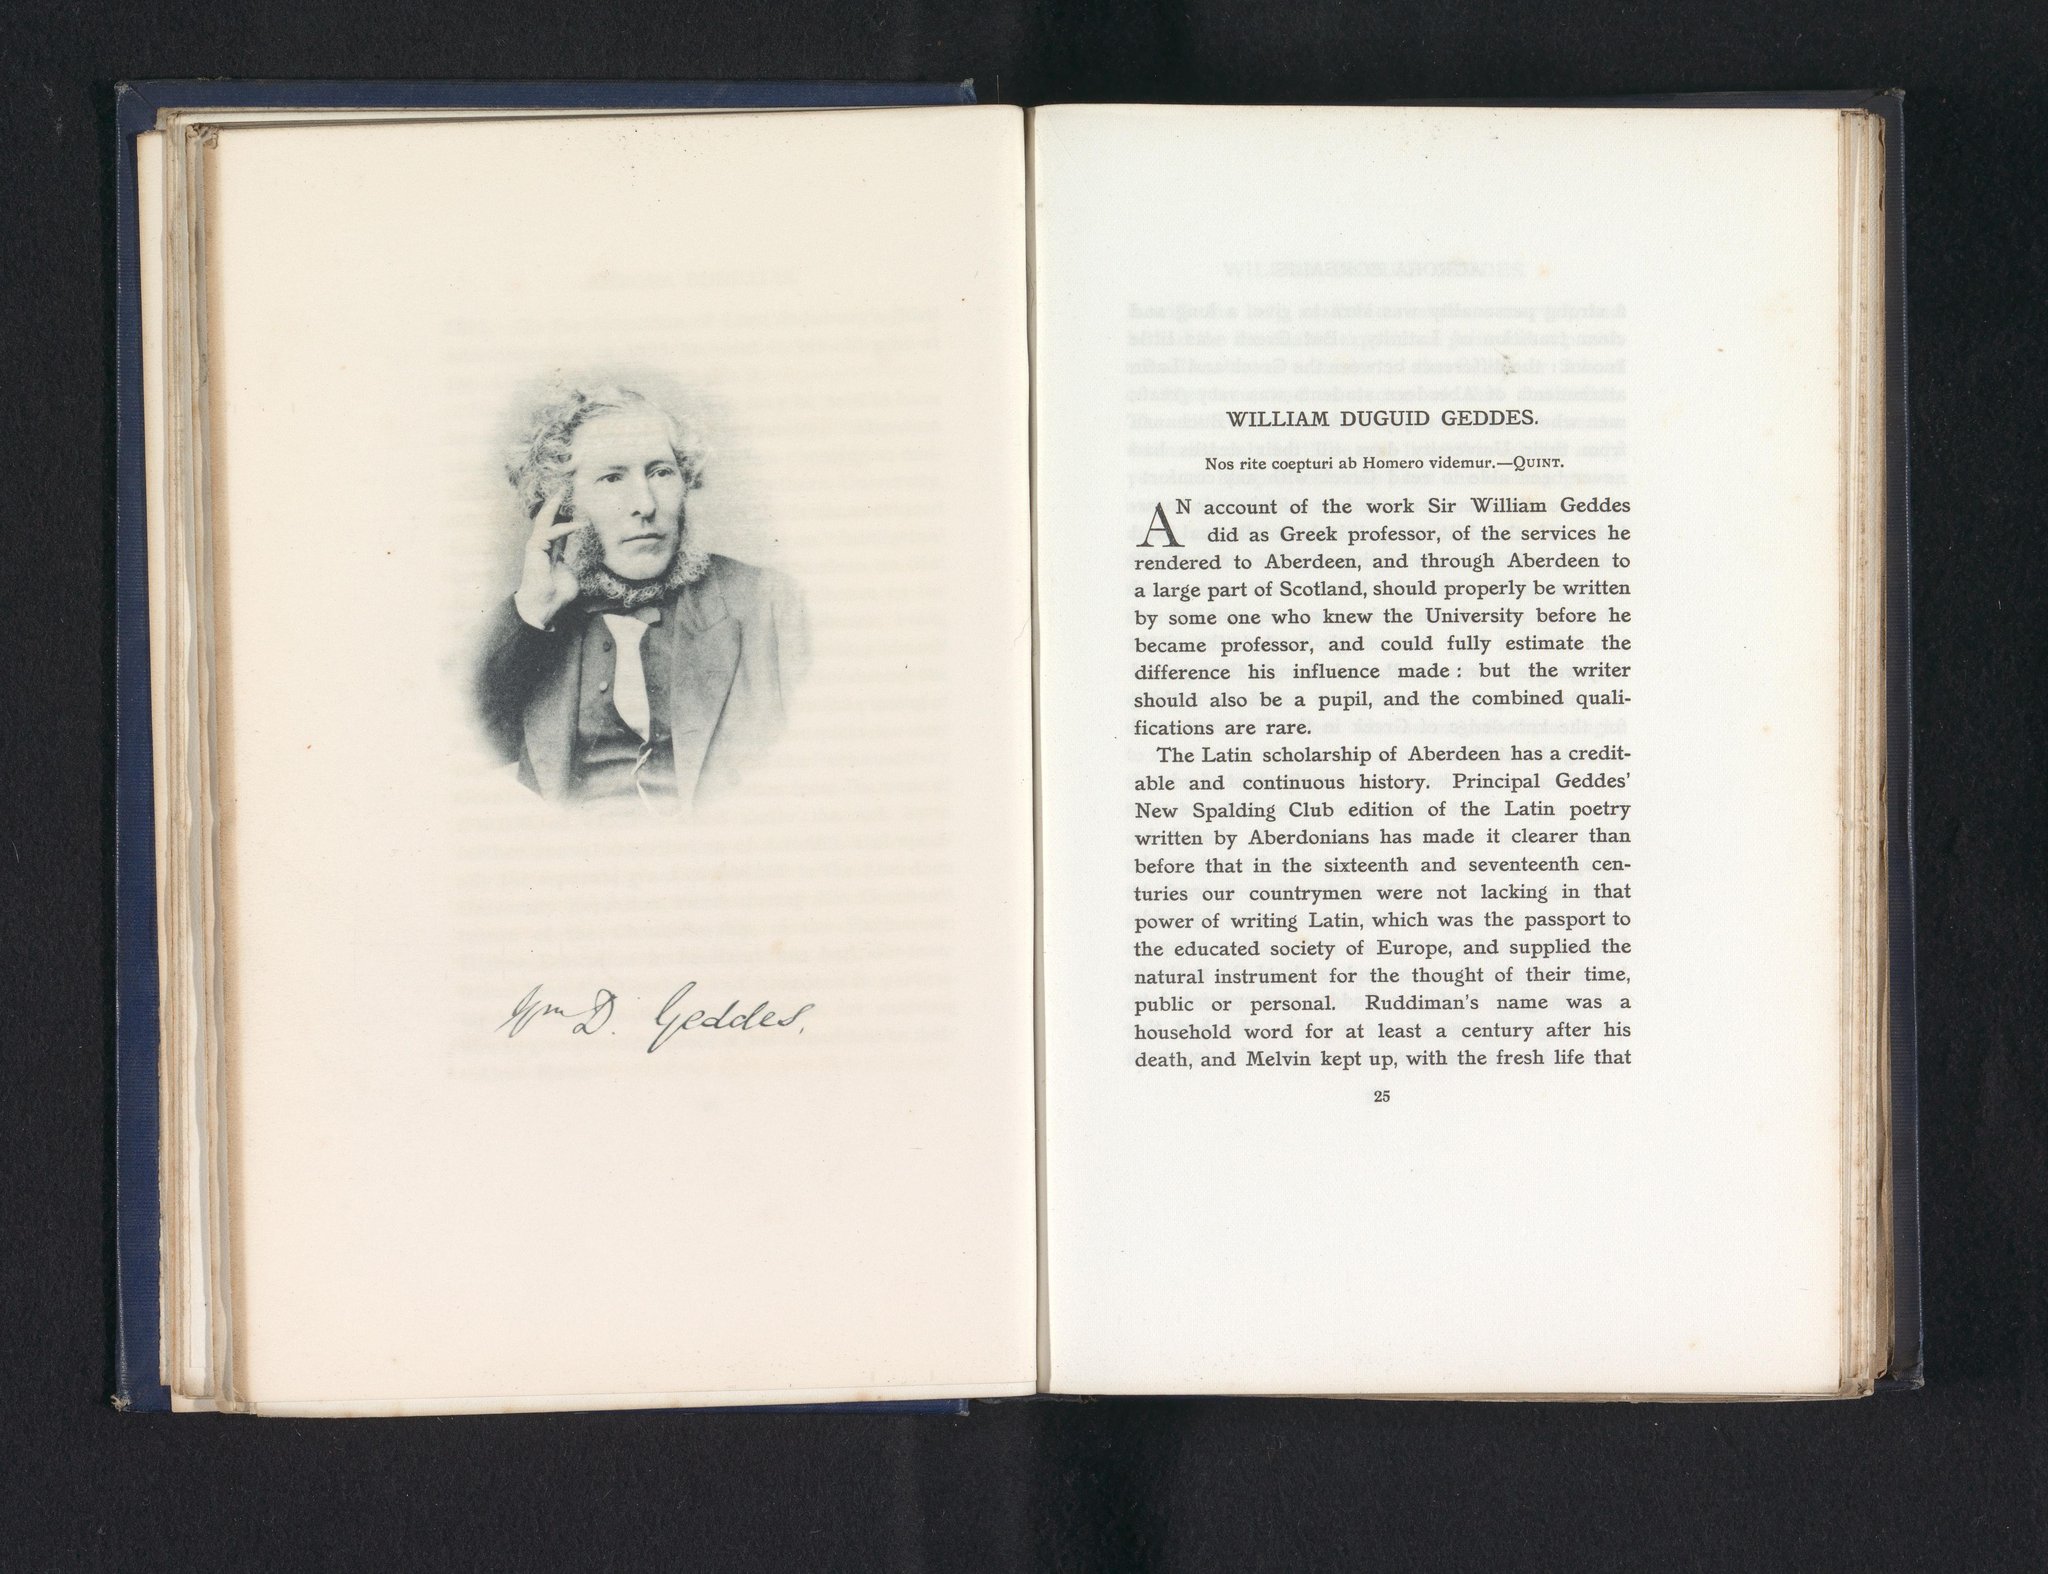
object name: page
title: Portret van William Duguid Geddes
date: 1889-1899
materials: paper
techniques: photograph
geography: aberdeen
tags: scholar, philosopher